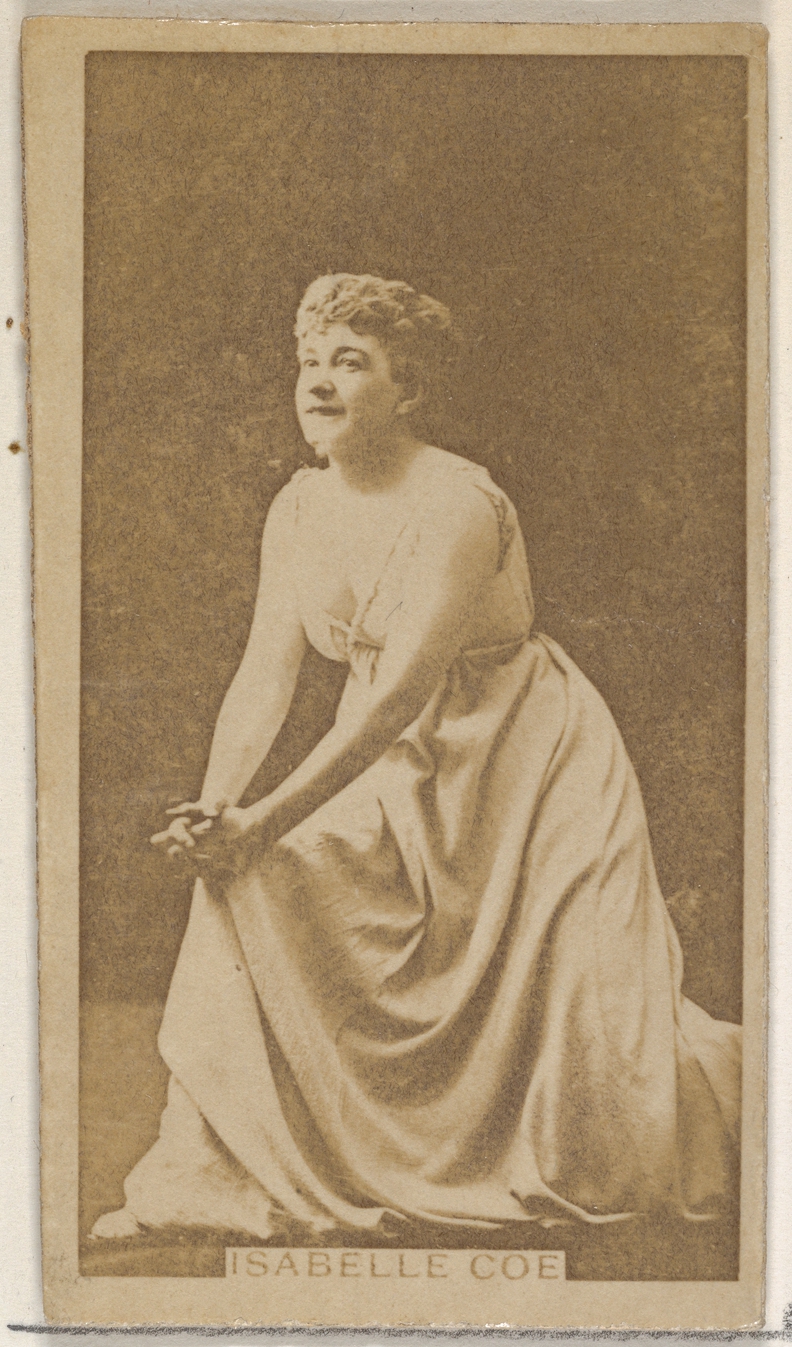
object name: photograph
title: Isabelle Coe, from the Actors and Actresses series (N45, Type 8) for Virginia Brights Cigarettes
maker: allen & ginter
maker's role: publisher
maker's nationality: american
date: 1888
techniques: albumen silver print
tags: portraits,women,actresses